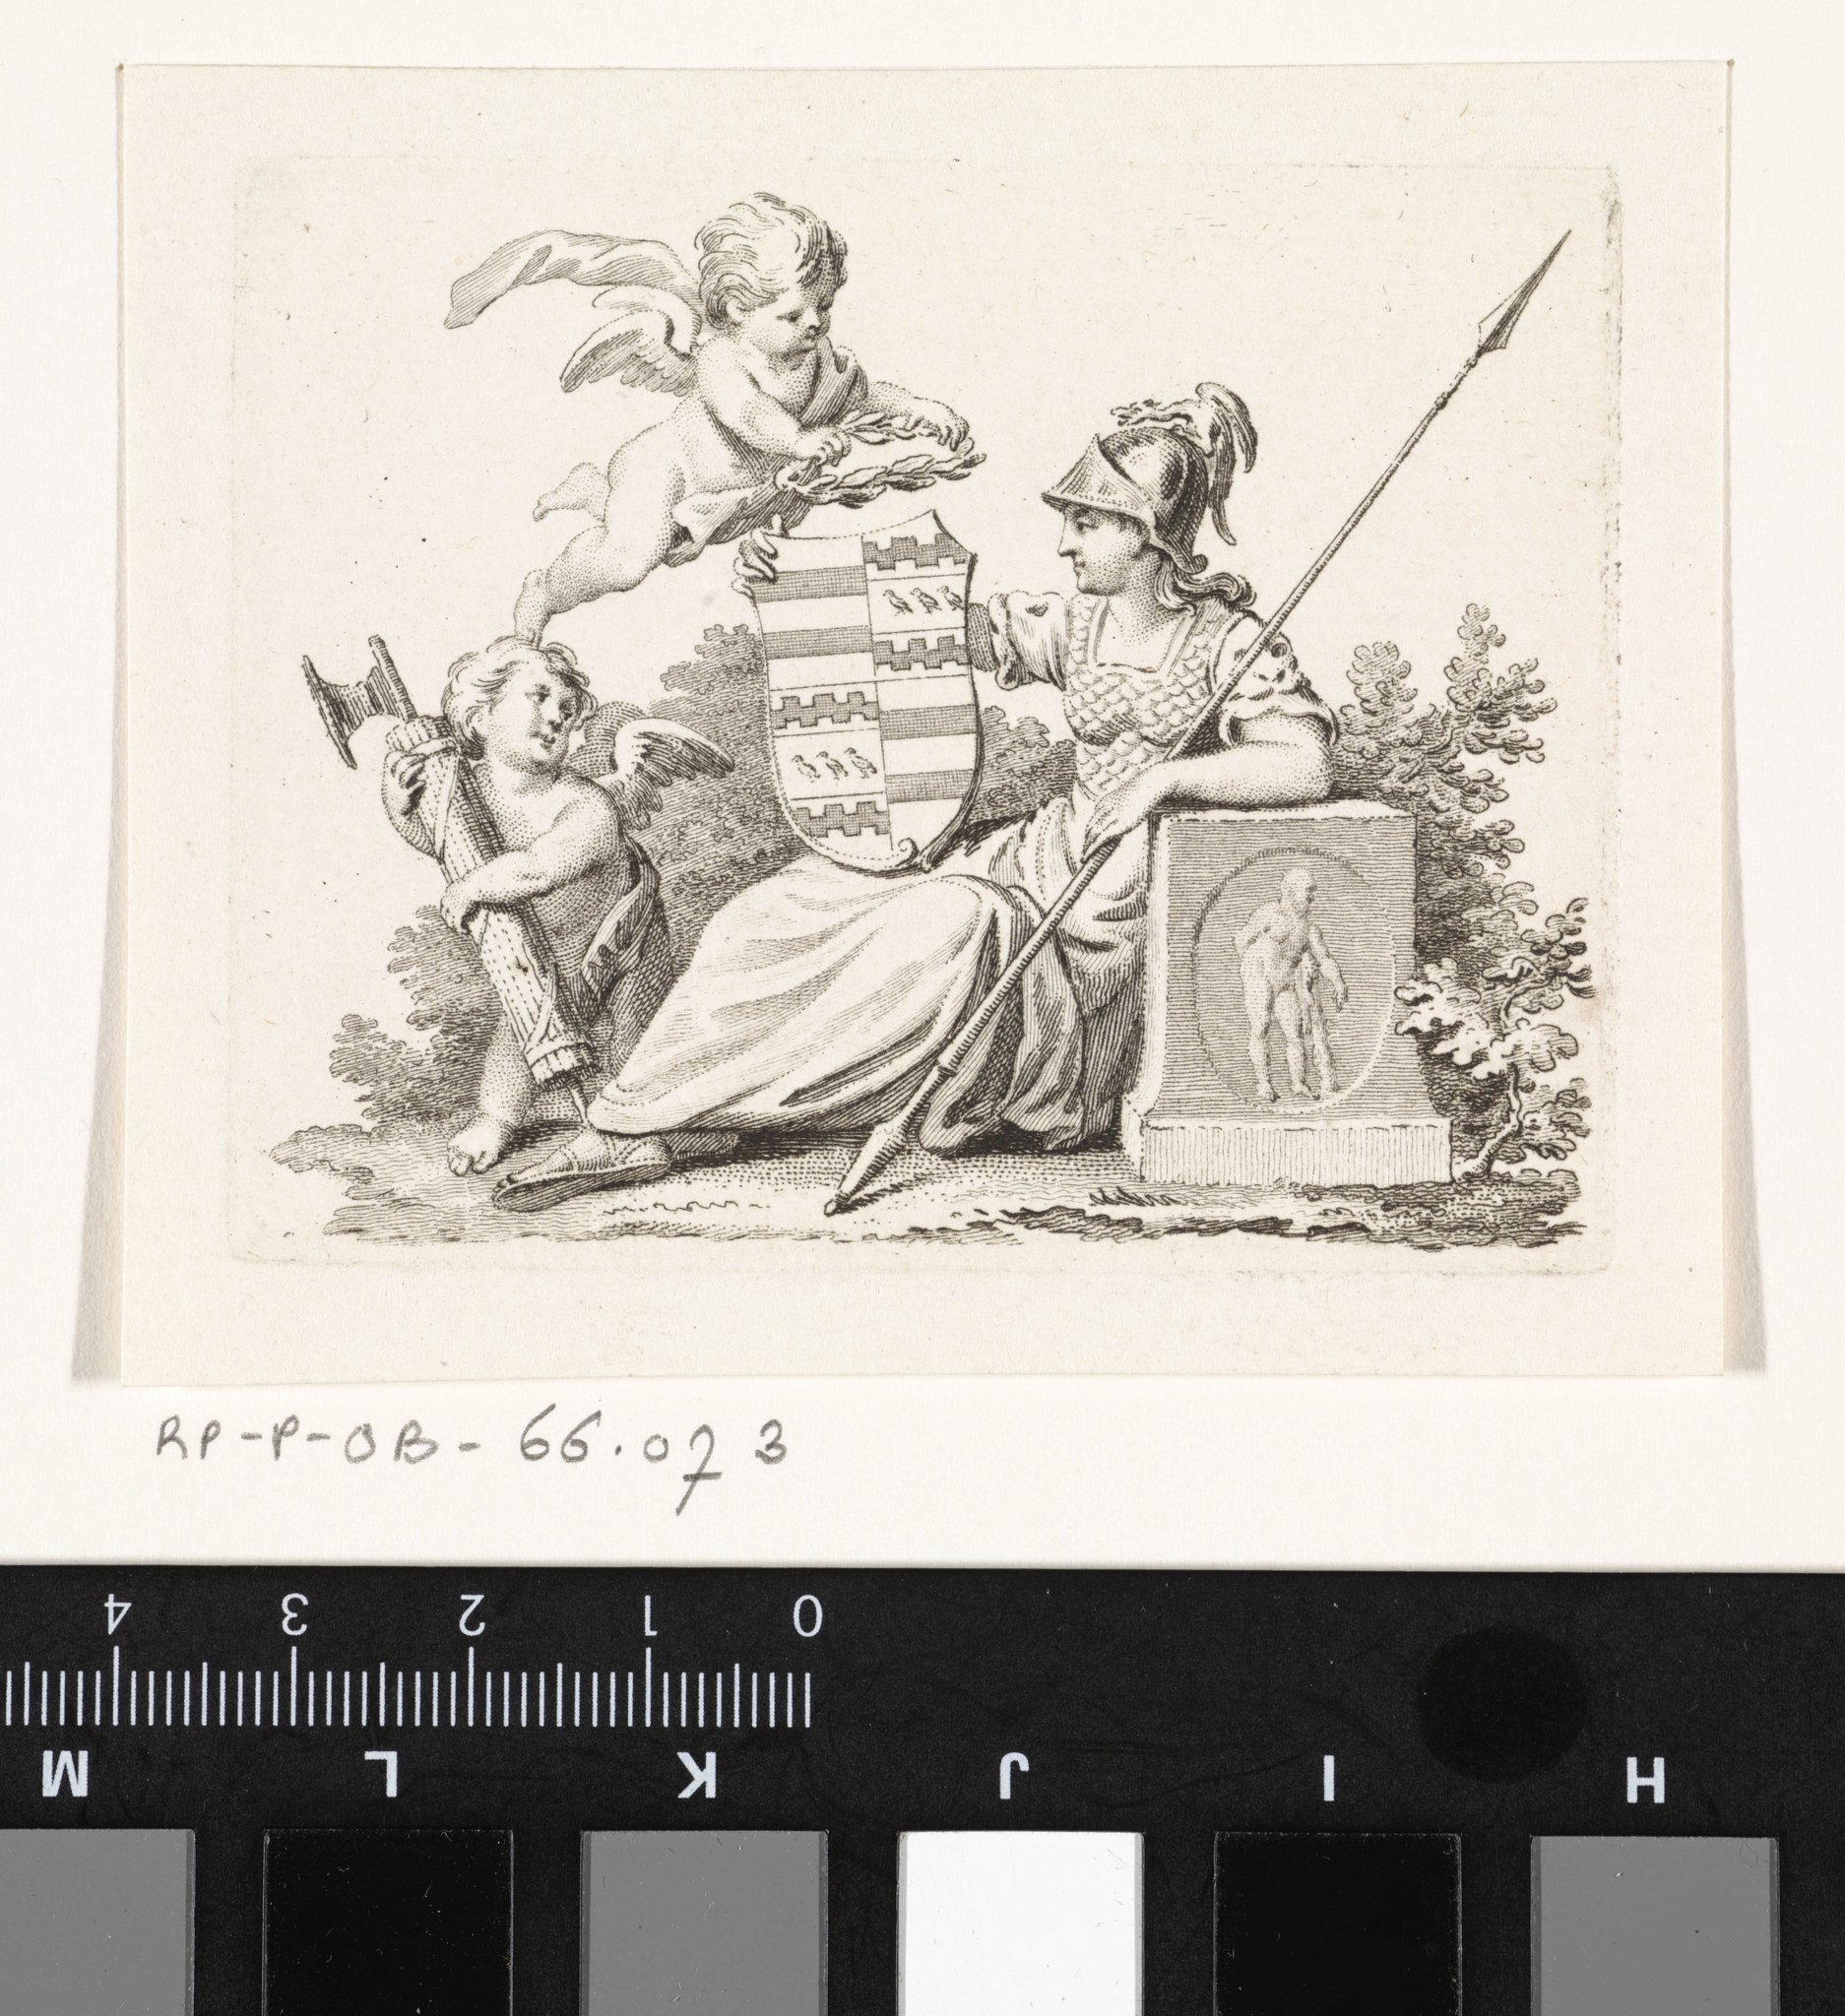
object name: print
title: Vignet met een vrouw met een onbekend wapen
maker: reinier vinkeles (i)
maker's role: draughtsman, print maker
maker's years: 1741-1816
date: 1751-1816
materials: paper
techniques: engraving, etching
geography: amsterdam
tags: cupids: 'amores', 'amoretti', 'putti', armorial bearing, heraldry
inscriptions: collector's mark: Lugt 240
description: Bij een voetstuk zit een gehelmde vrouw met een onbekend familiewapen. Een putto kroont het wapen met een lauwerkrans terwijl een tweede putto met een fasces aan komt lopen.